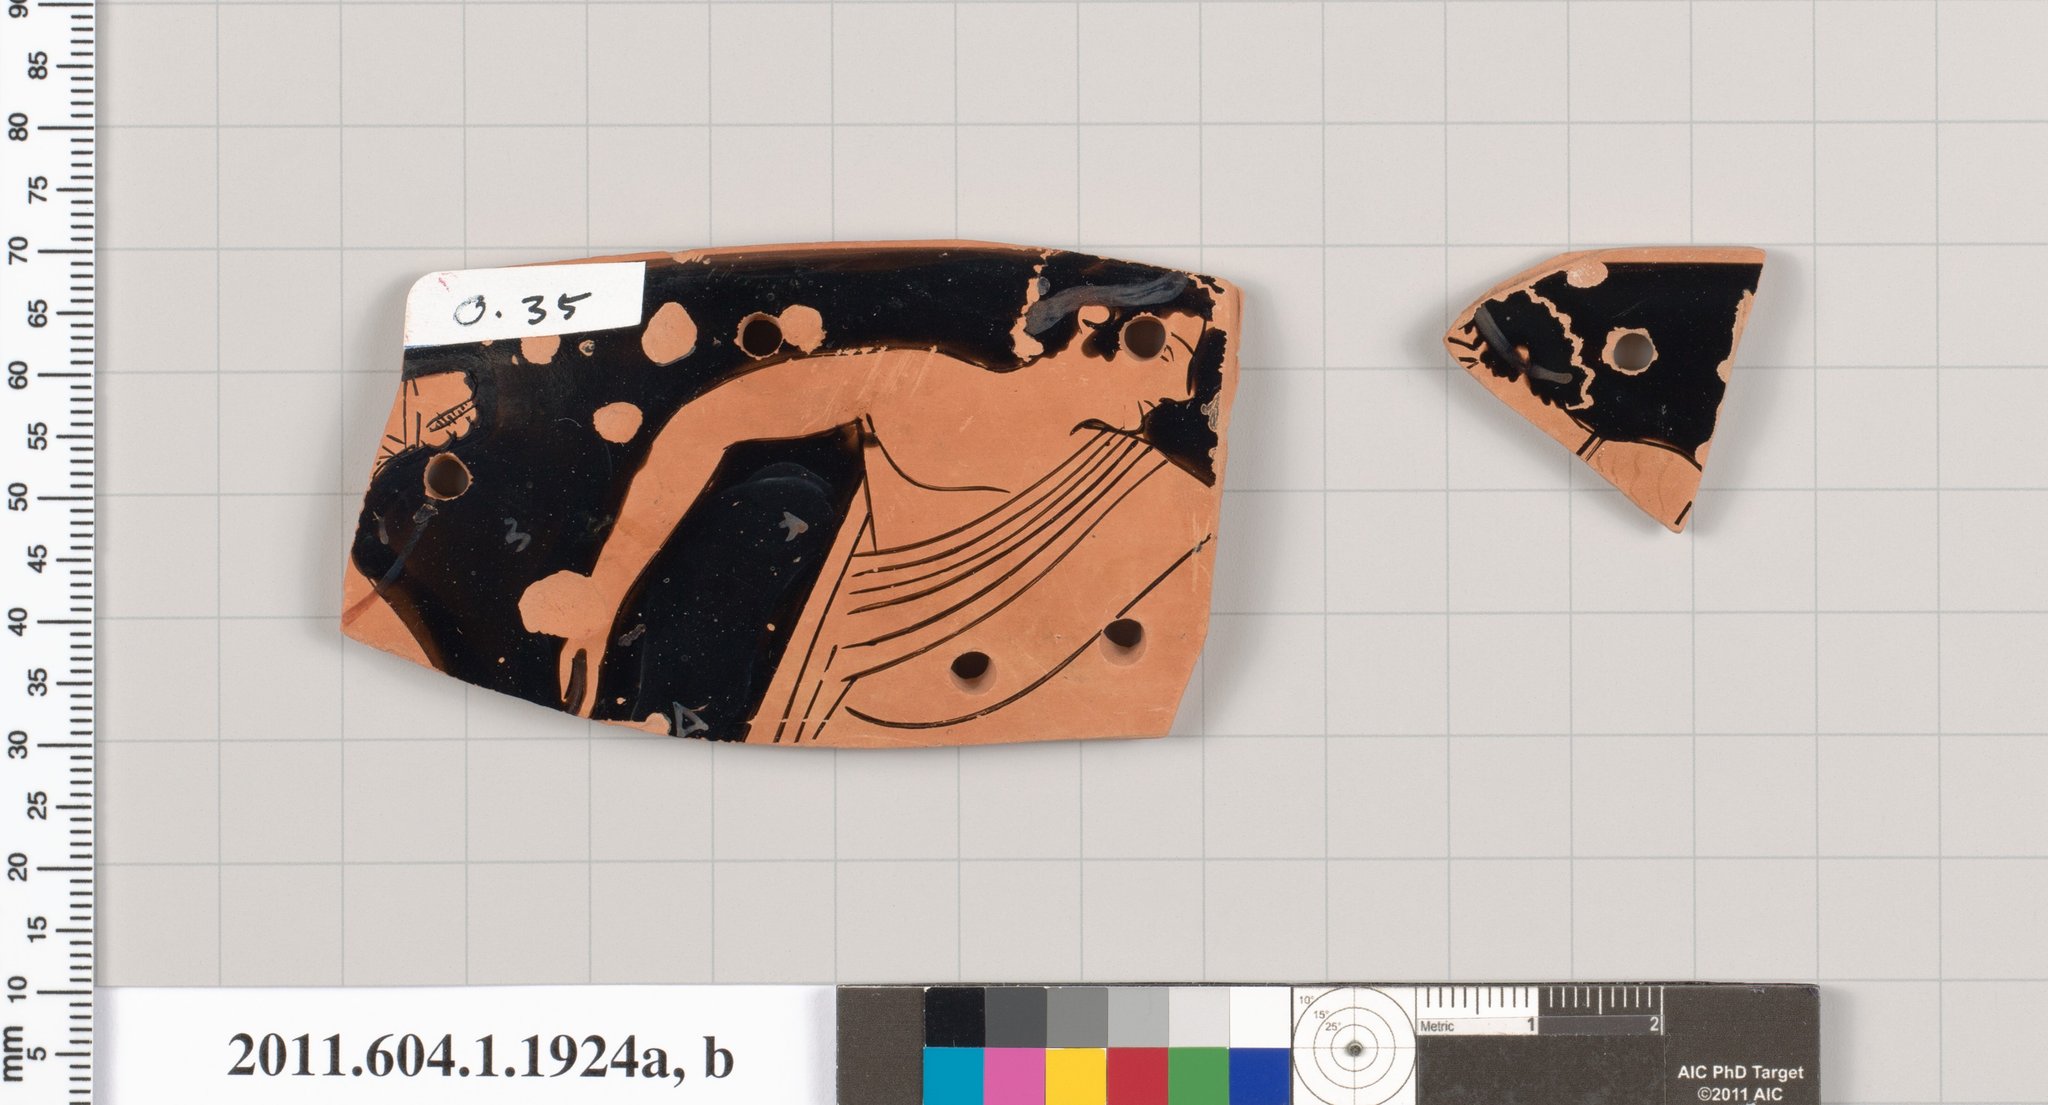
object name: kylix fragment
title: Terracotta rim fragments of a kylix (drinking cup)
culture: greek, attic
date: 534-501 BCE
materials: terracotta